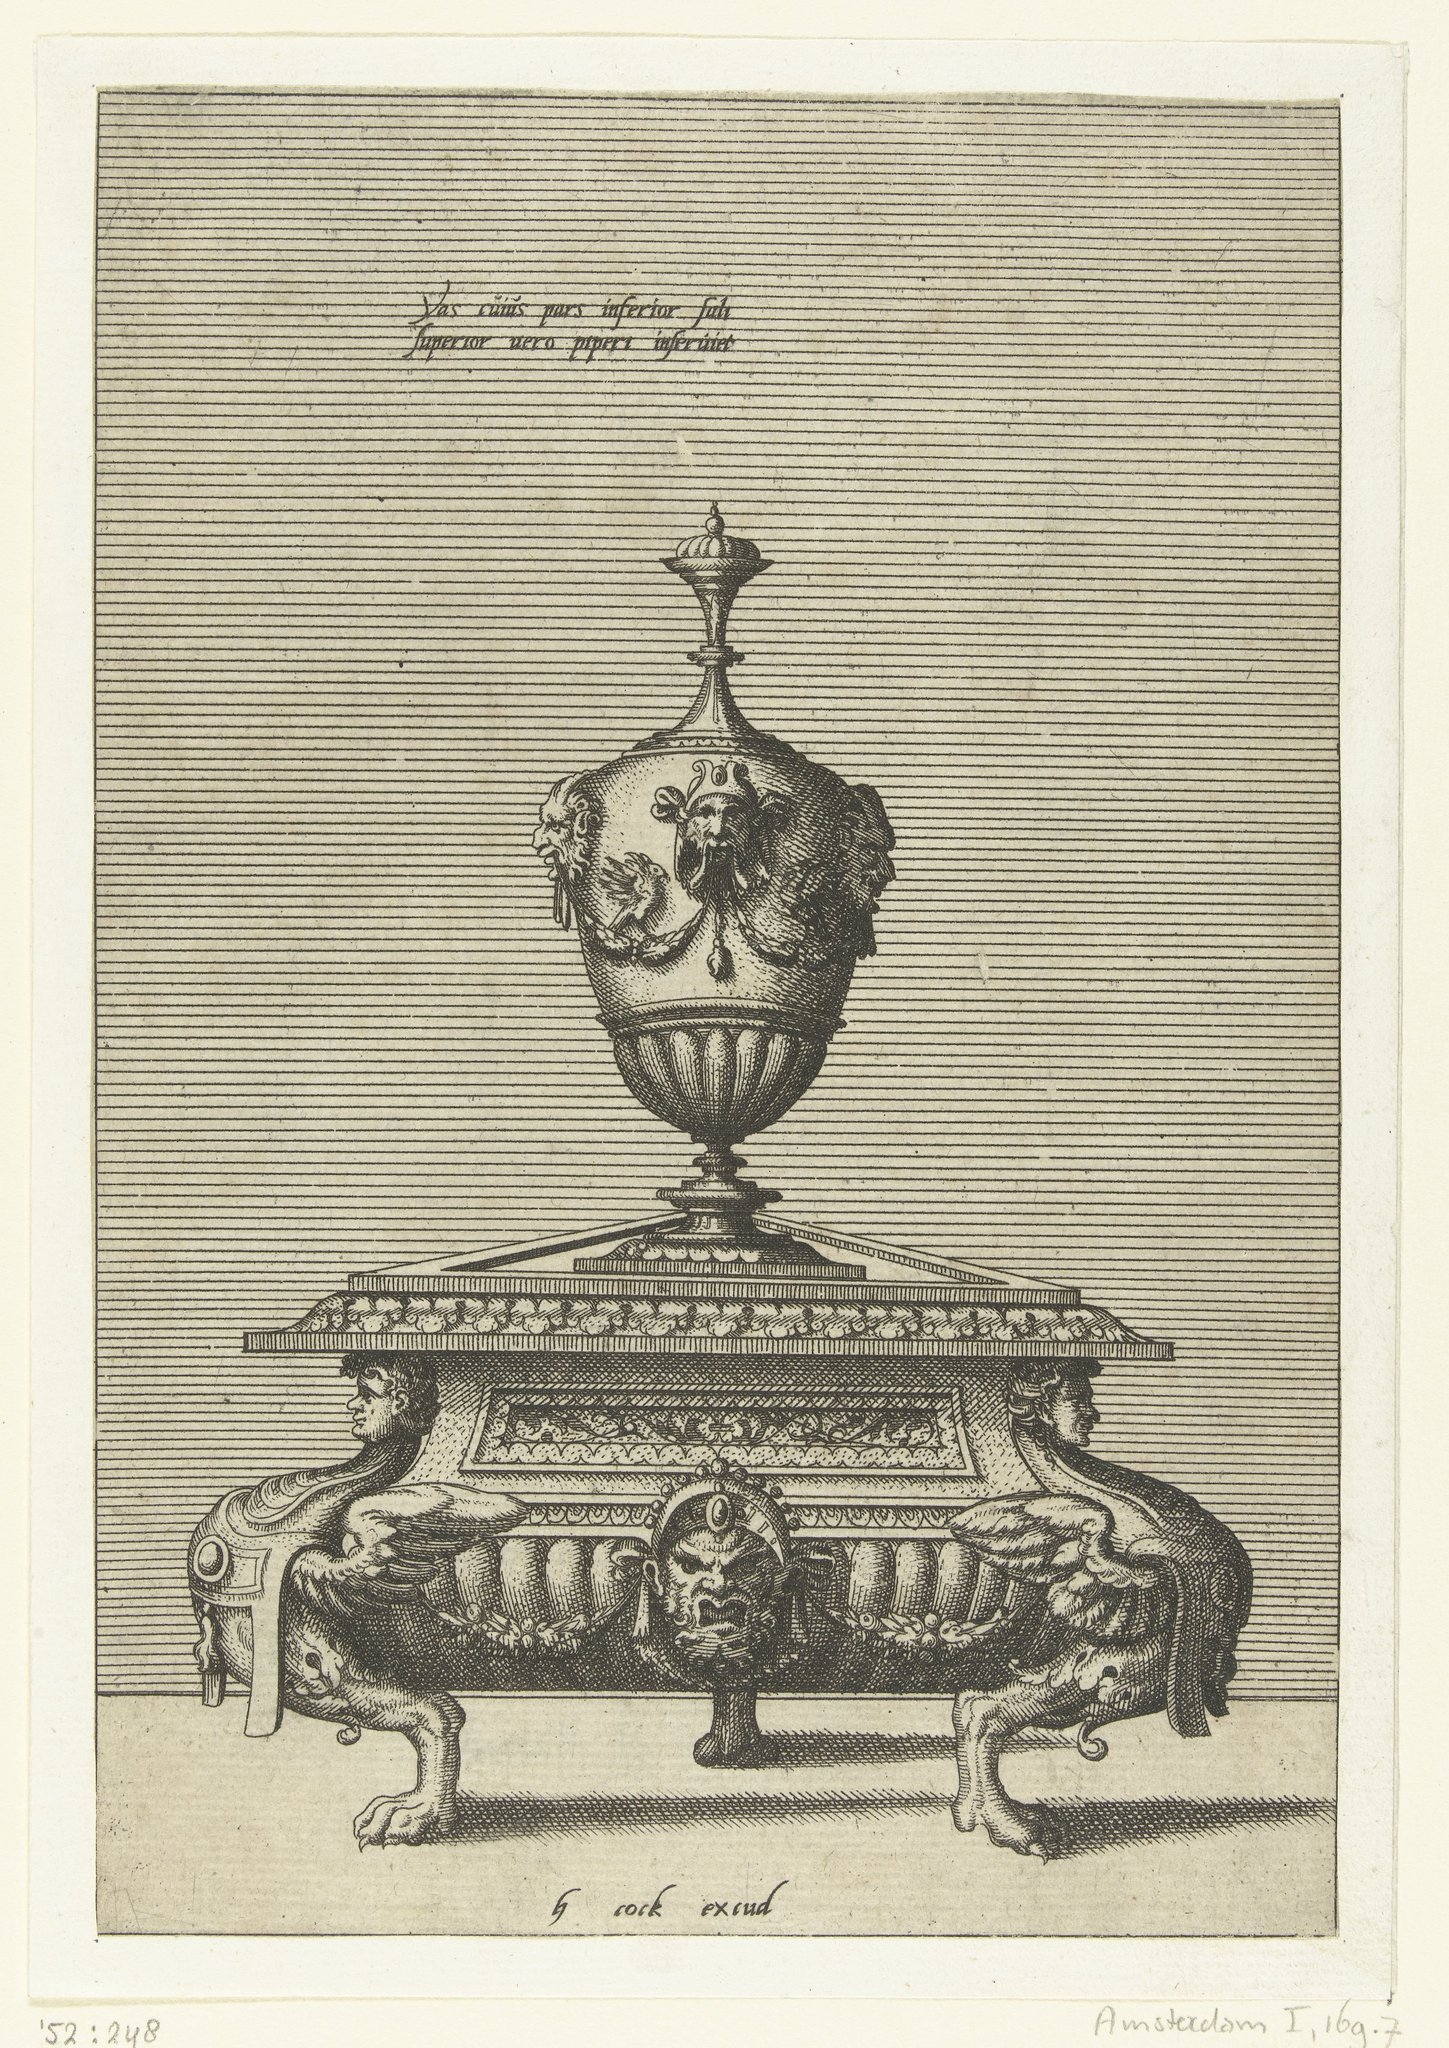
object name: ornament print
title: Vaatwerk zoals kannen, peper- en zoutvaten en een drinkschaal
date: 1563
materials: paper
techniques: etching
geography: netherlands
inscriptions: inscription: ‘h cock excud.’, inscription: ‘Vas cuius pars inferior sali/superior uero piperi inferuiet’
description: Het driehoekige zoutvat wordt gedragen door sfinxen. Het daarop staande gedeelte voor peper heeft de vorm van een vaas. Horizontaal gearceerde achtergrond. Uit serie van 12 bladen.